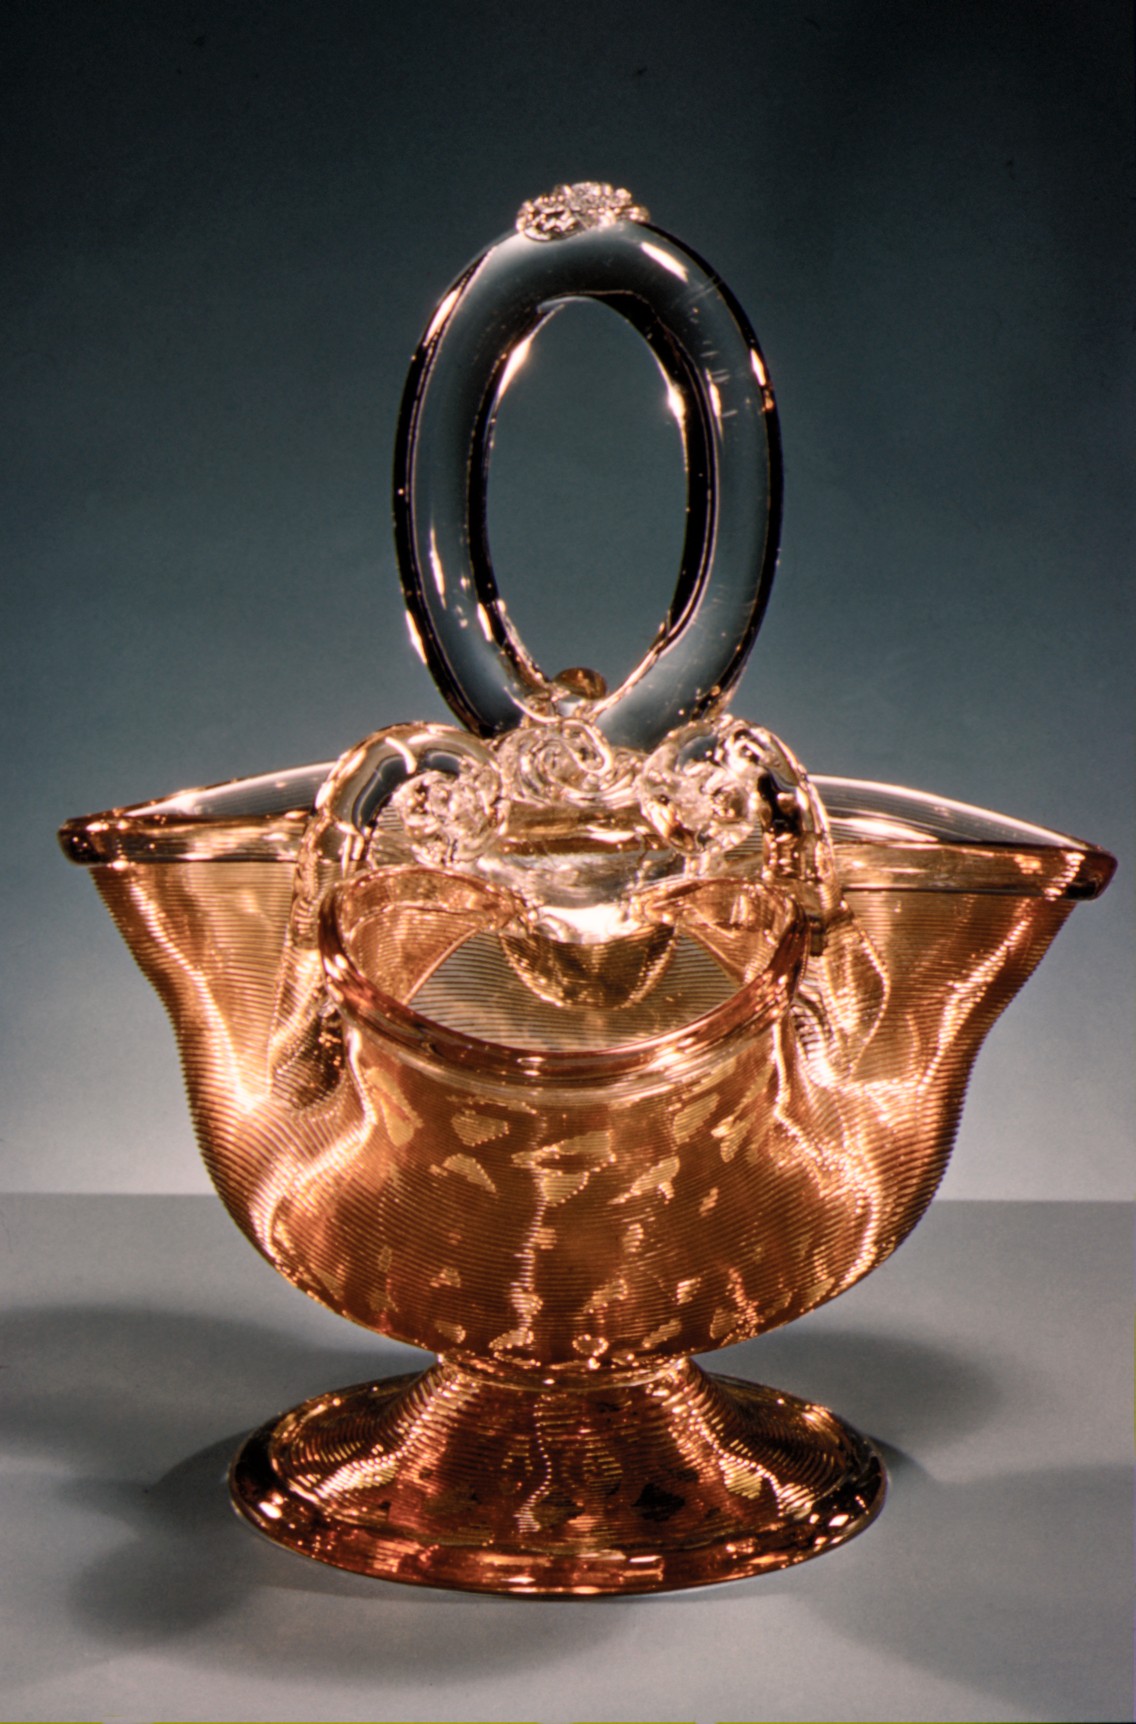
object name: basket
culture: american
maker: boston & sandwich glass company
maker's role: maker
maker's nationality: american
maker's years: 1825-1888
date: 1880-1888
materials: amber, glass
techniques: glassblowing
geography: united states